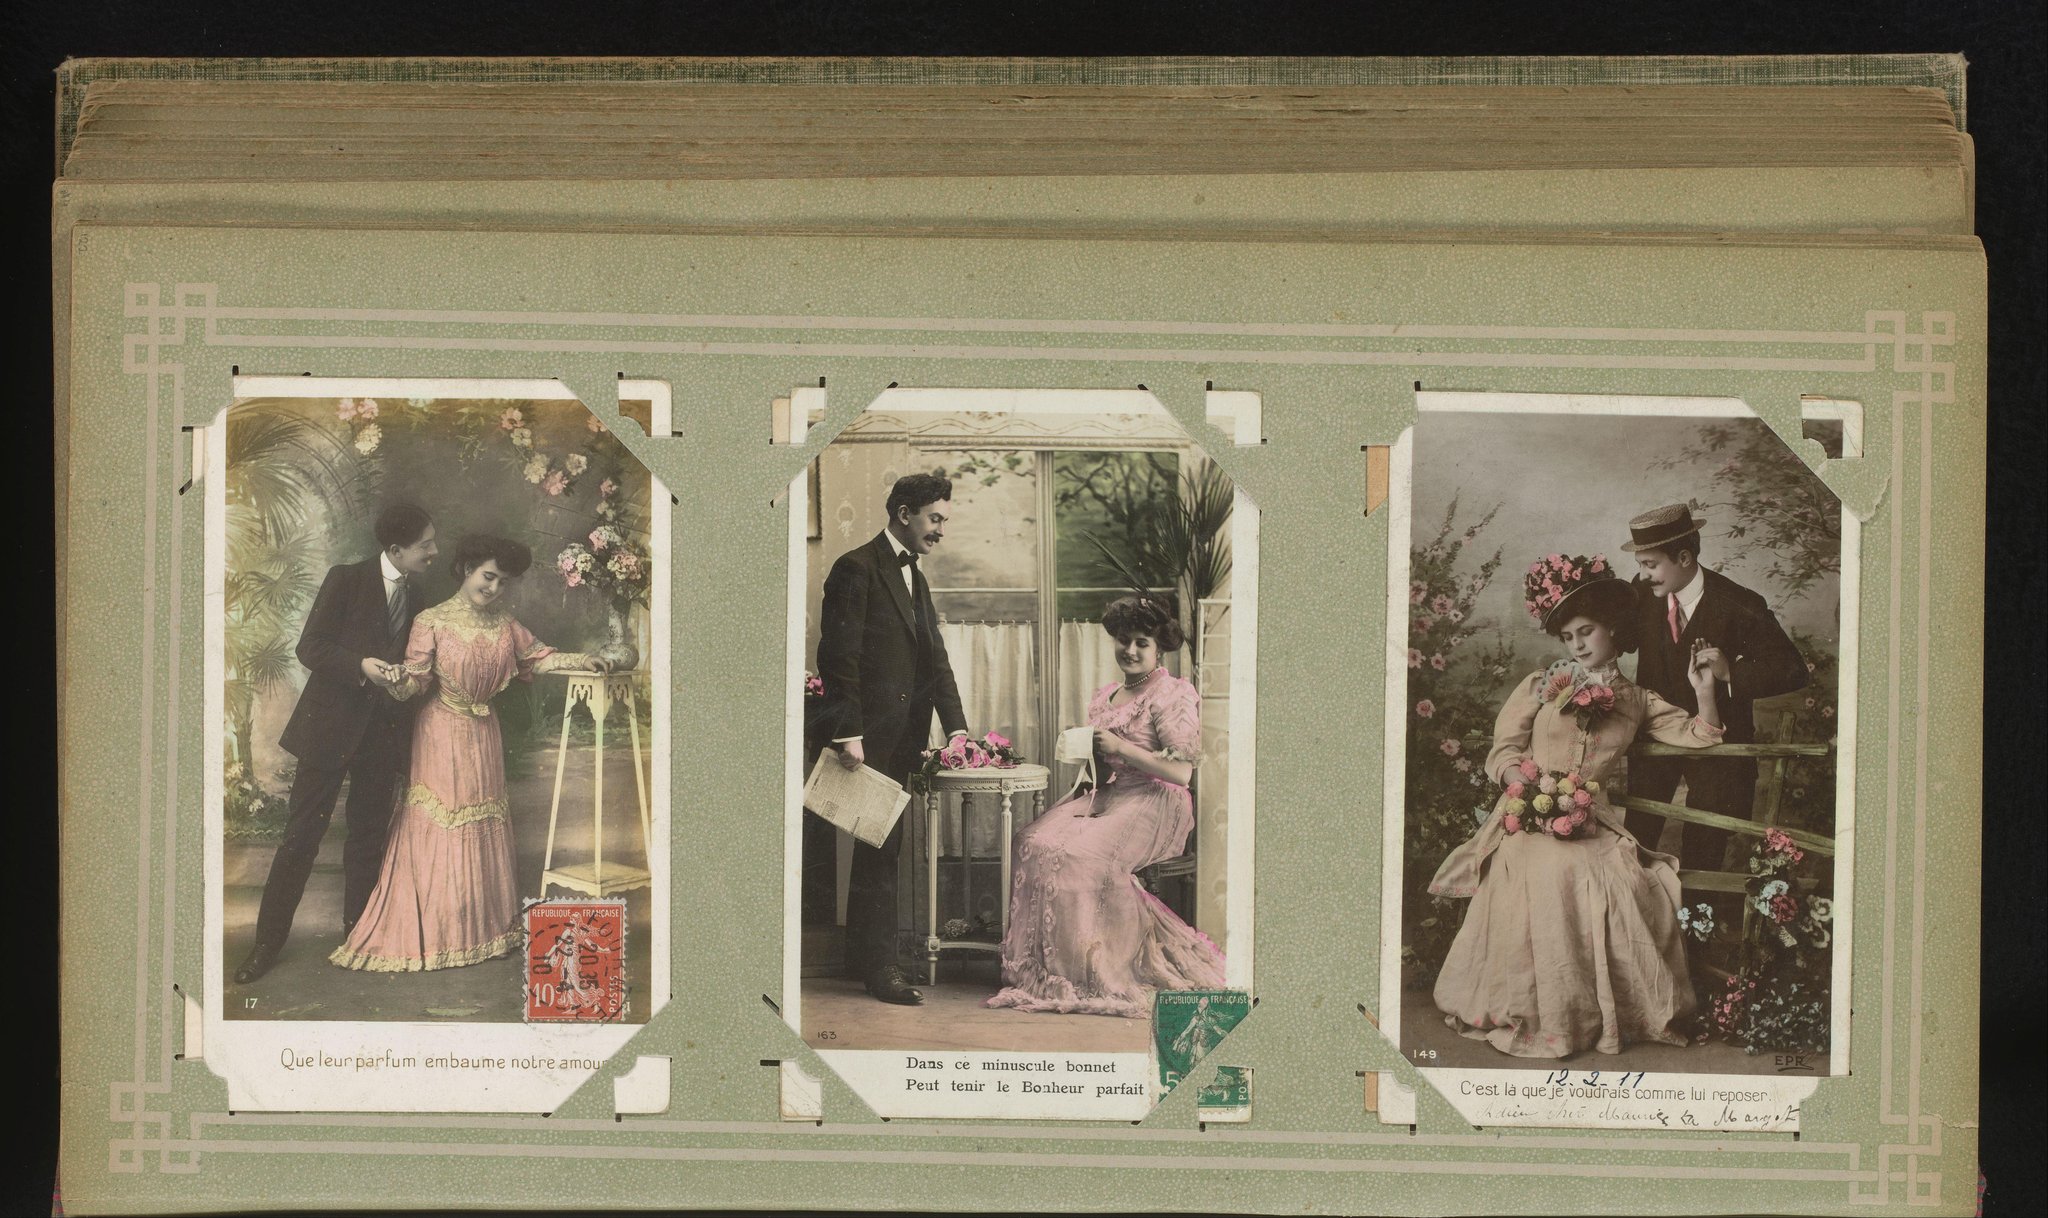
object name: photograph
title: Drie portretten van een paar geliefden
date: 1900-1930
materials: cardboard, ink, photographic support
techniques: gelatin silver print, hand coloring, pen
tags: historical persons - bb - woman, historical persons, couple of lovers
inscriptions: monogram: ‘EPR’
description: Deze foto's maken deel uit van een album.